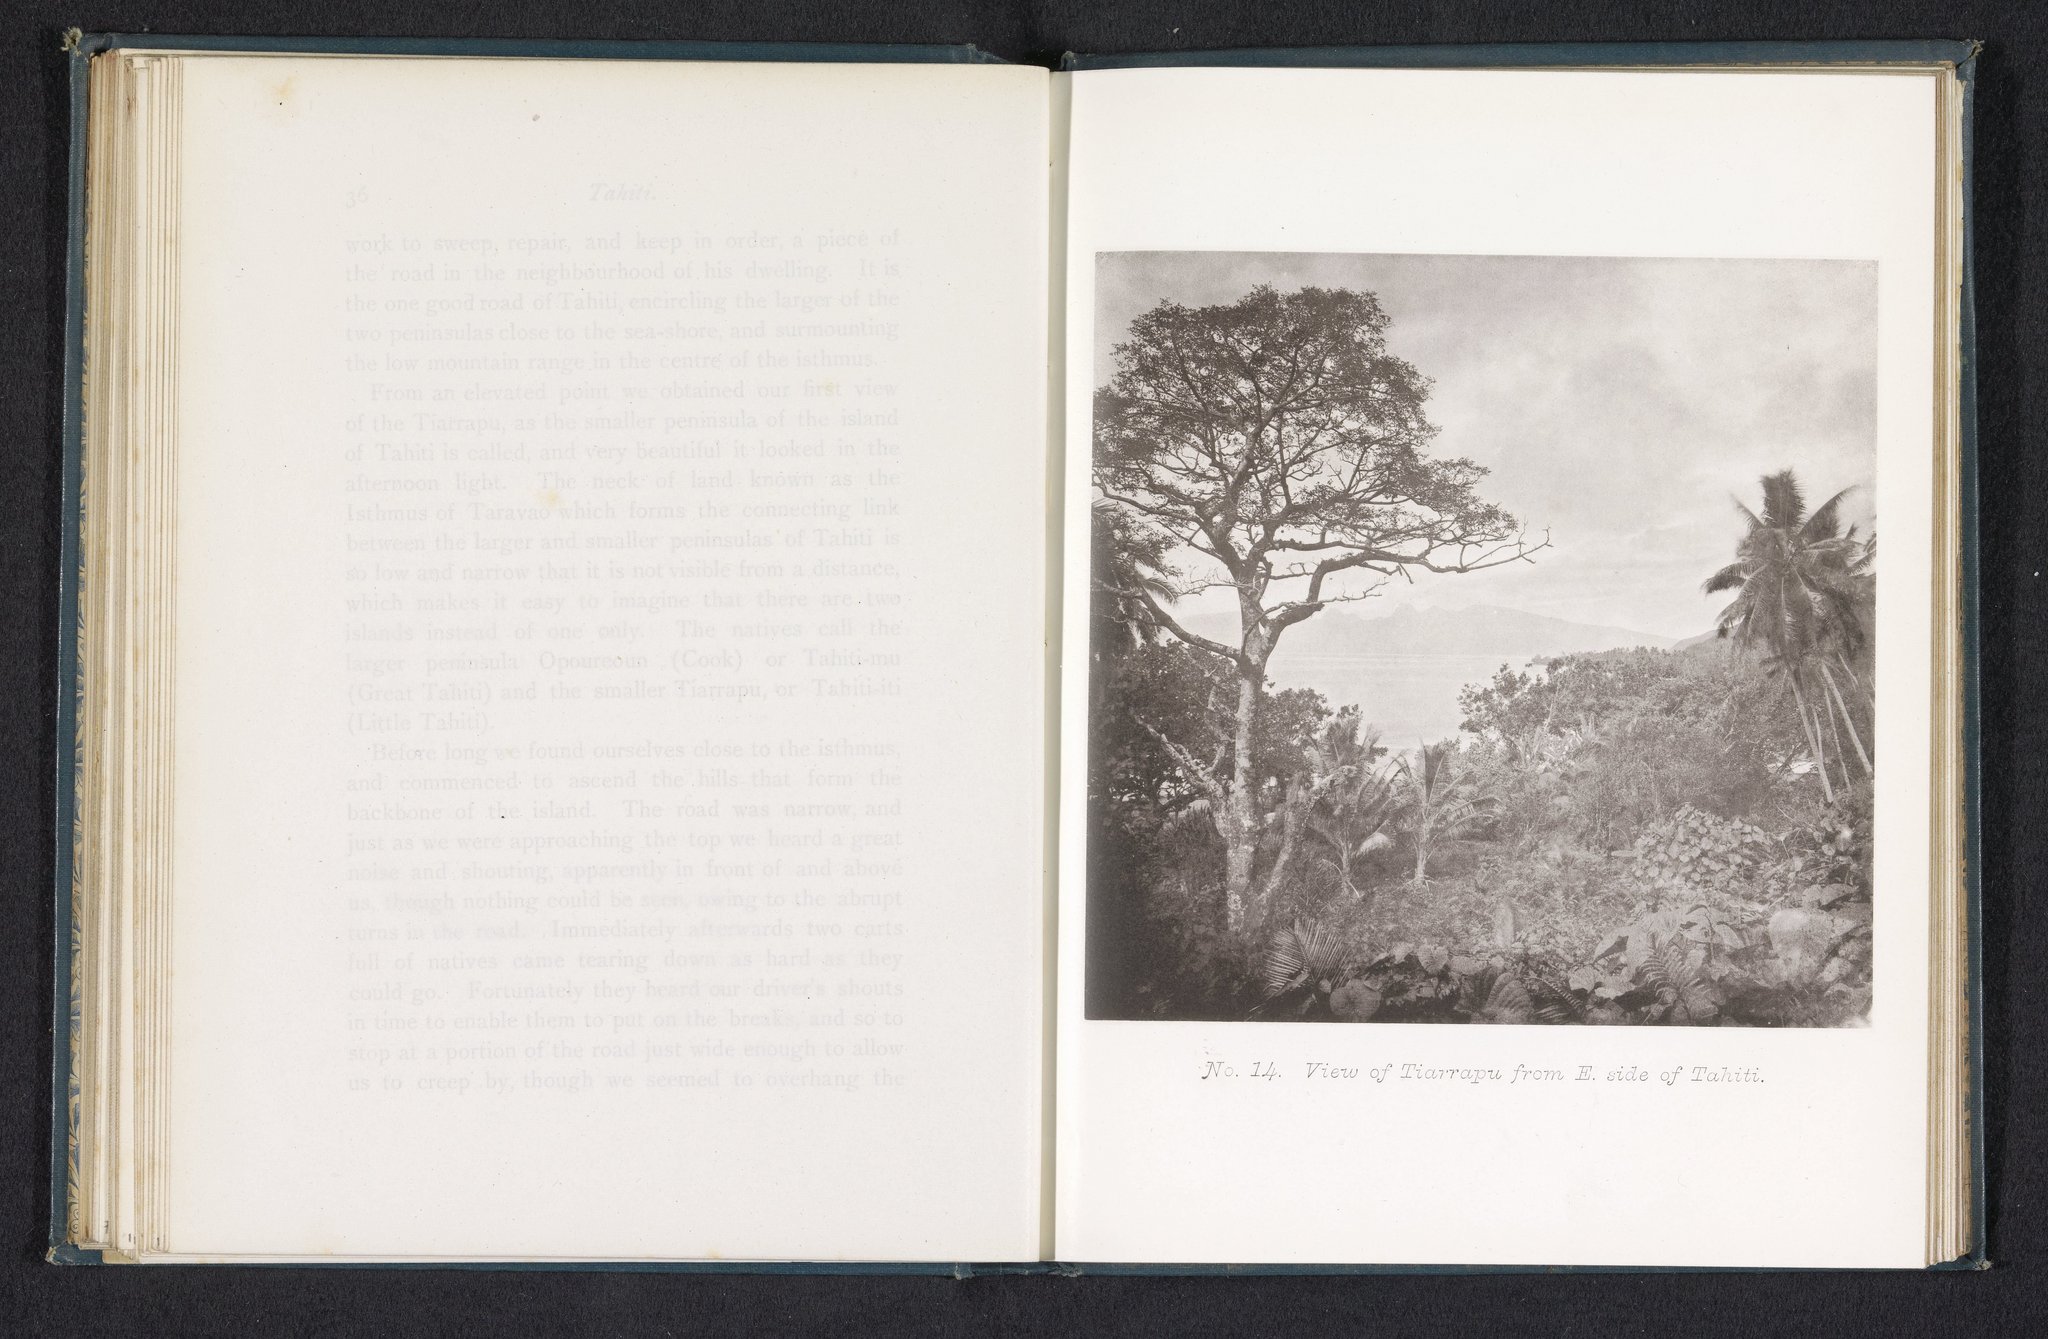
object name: page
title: Gezicht op een eiland vanaf Tahiti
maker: henry stuart-wortley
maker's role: fotograaf, kolonel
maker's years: 1832-1890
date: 1880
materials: paper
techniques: photograph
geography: tahiti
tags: island, trees: palm-tree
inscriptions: number: ‘No. 14.’